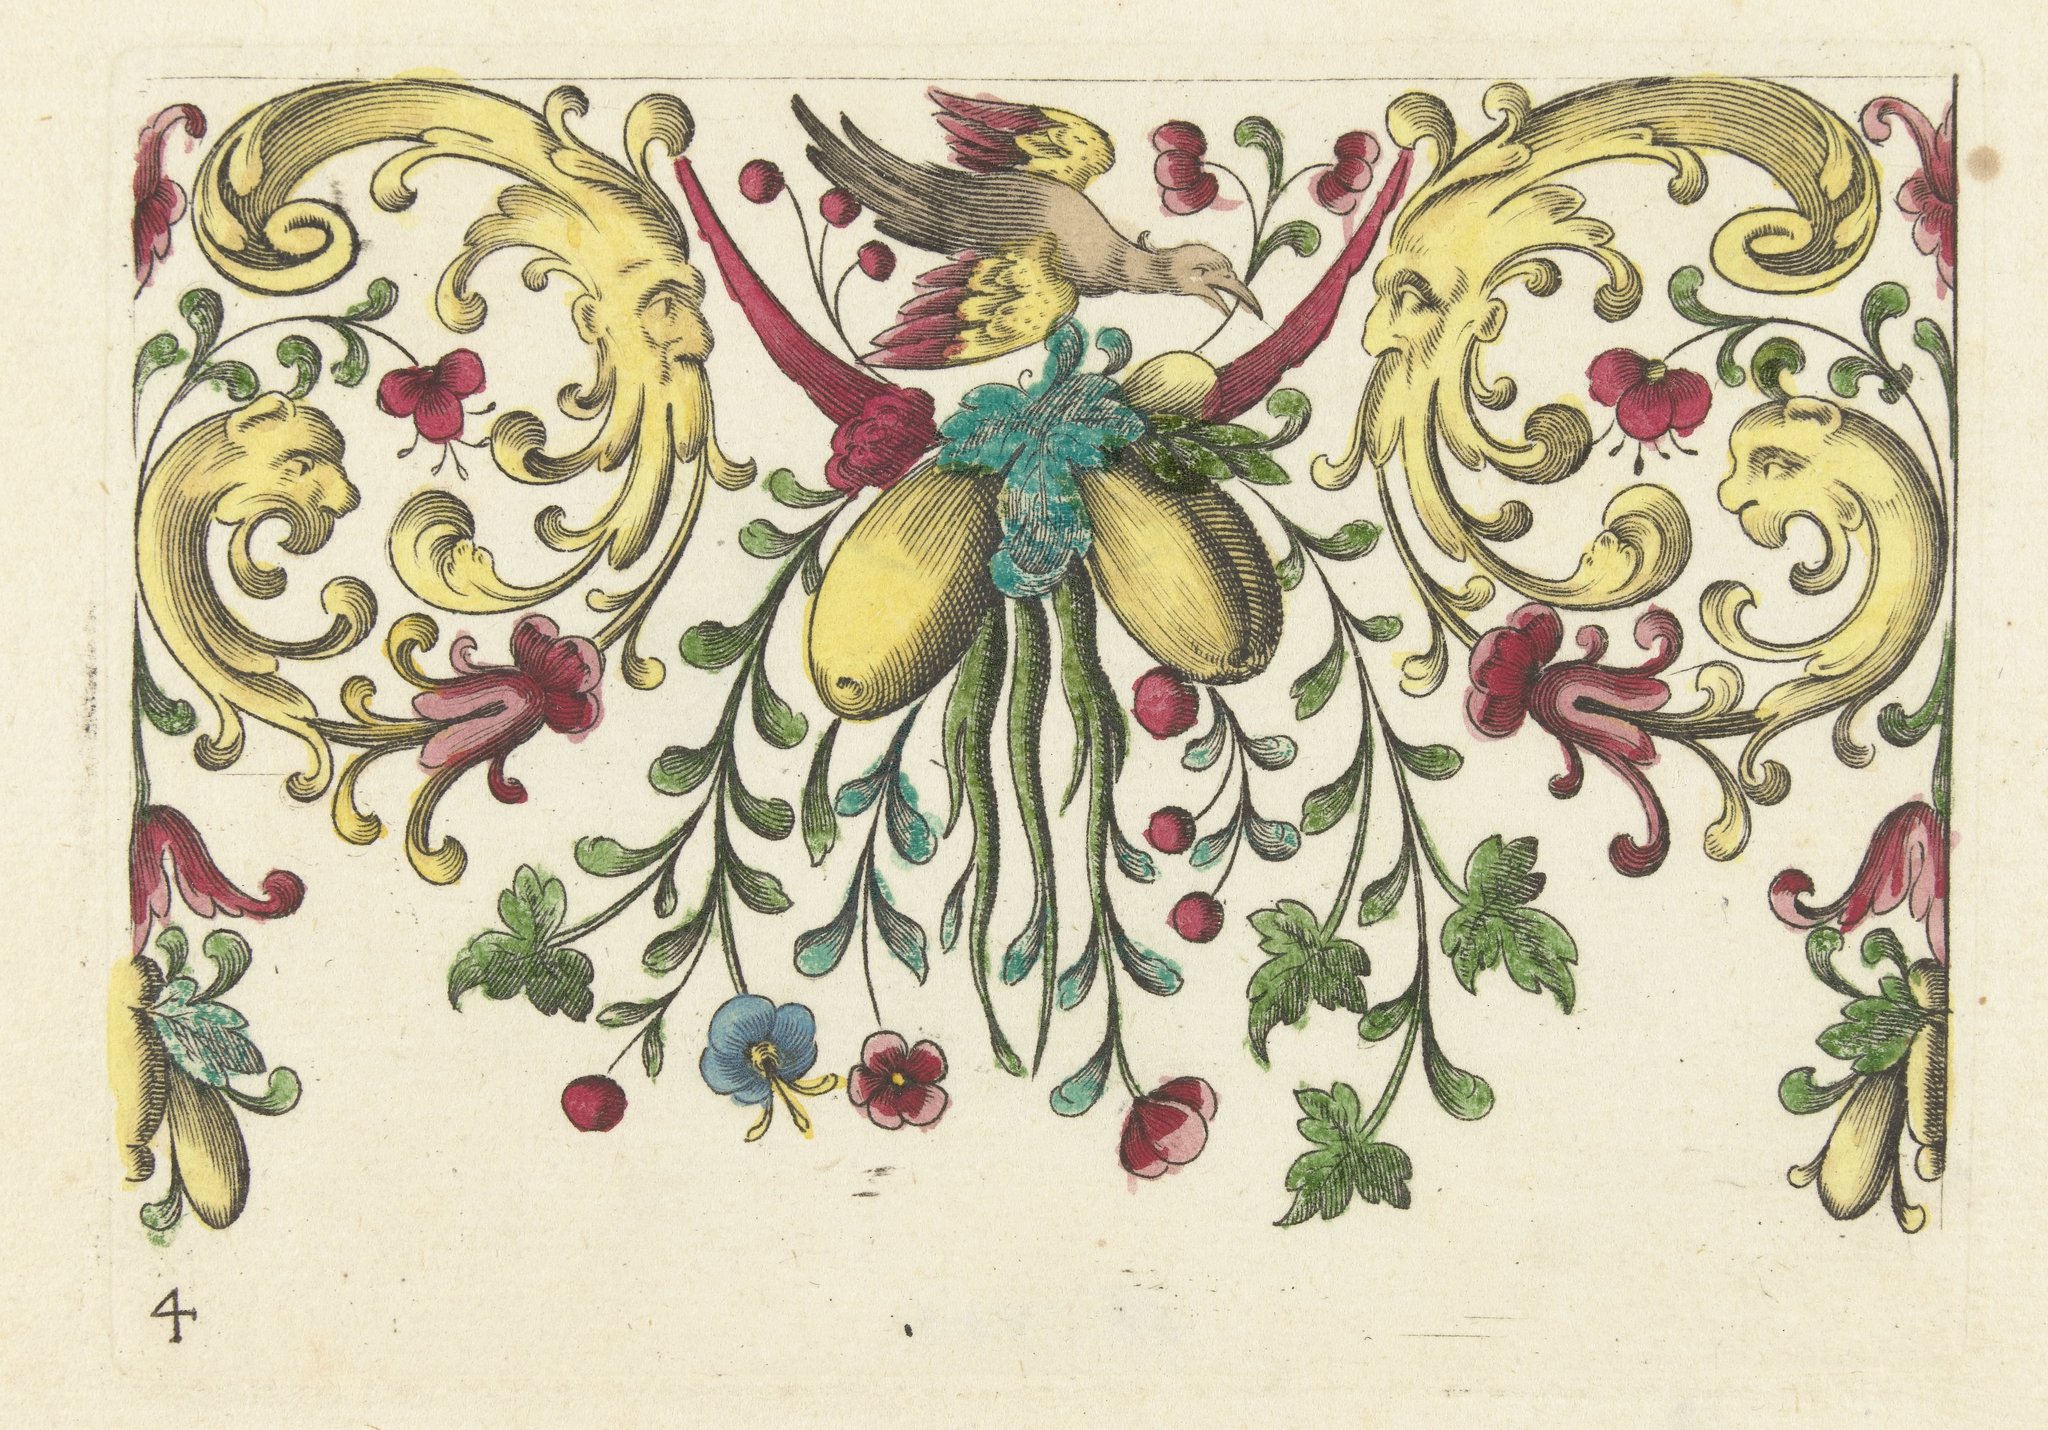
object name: ornament print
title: 8-bladige reeks: Früchten buchlein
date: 1596-1633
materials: paper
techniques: engraving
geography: germany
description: Blad uit een serie van 12 bladen, genummerd 1-8.